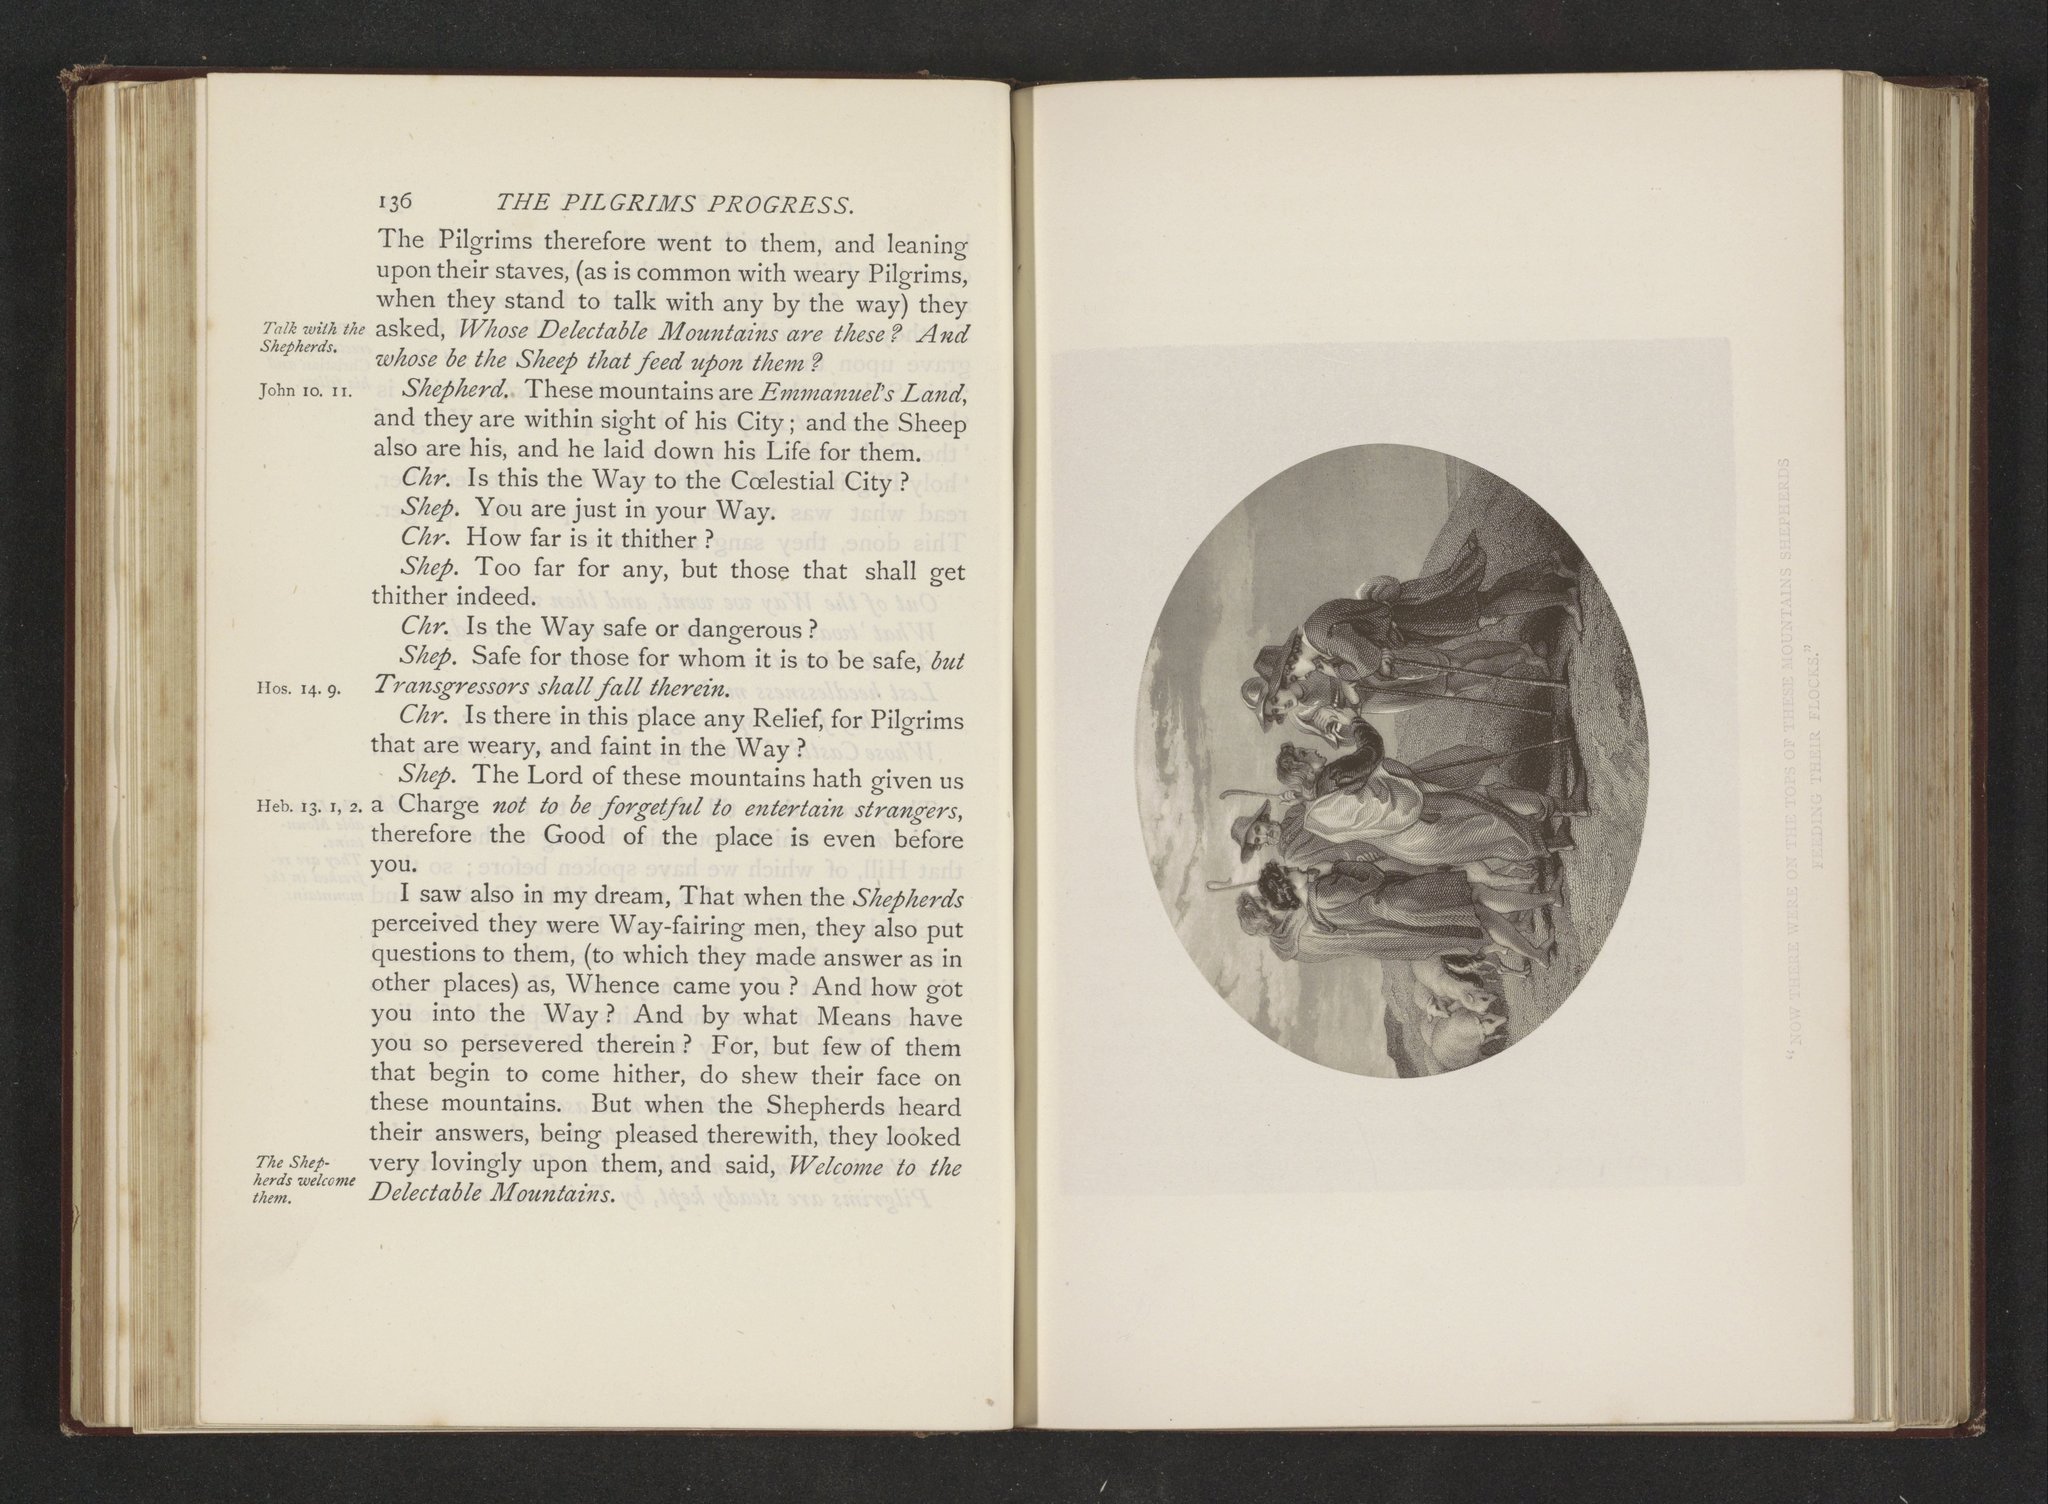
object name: photomechanical print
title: “Now there were on the tops of these Mountains Shepherds feeding their flocks.”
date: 1871-1881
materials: paper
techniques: woodburytype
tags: print, e.g.: engraving, etching, lithograph, herd, flock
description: Illustratie betreft Christen en vijf herders die hun schapen voeden.